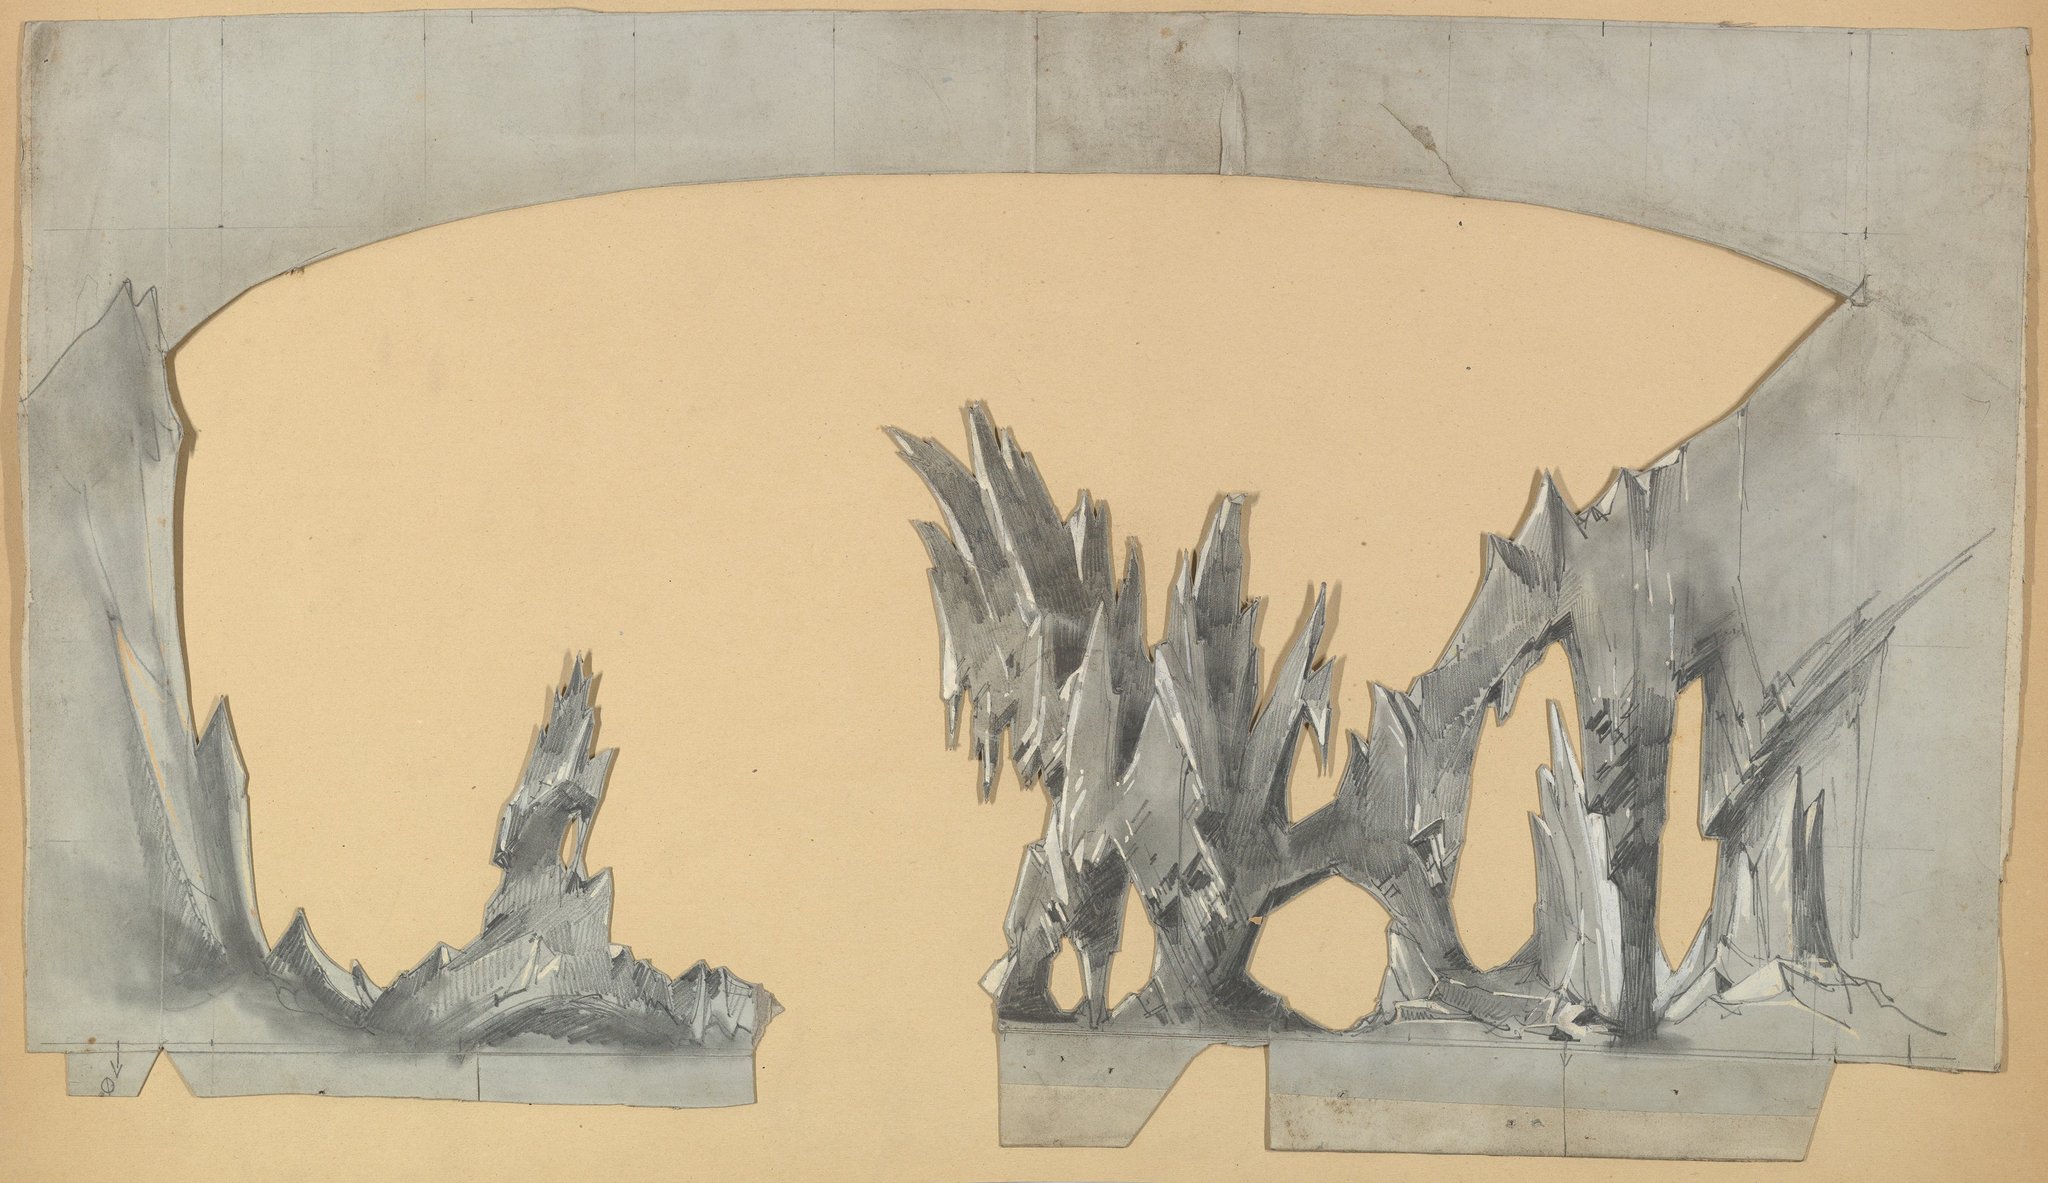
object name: drawing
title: Design for a Stage Set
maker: eugène cicéri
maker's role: artist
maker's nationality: french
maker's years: 1813-1890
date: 1830-1890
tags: stage design